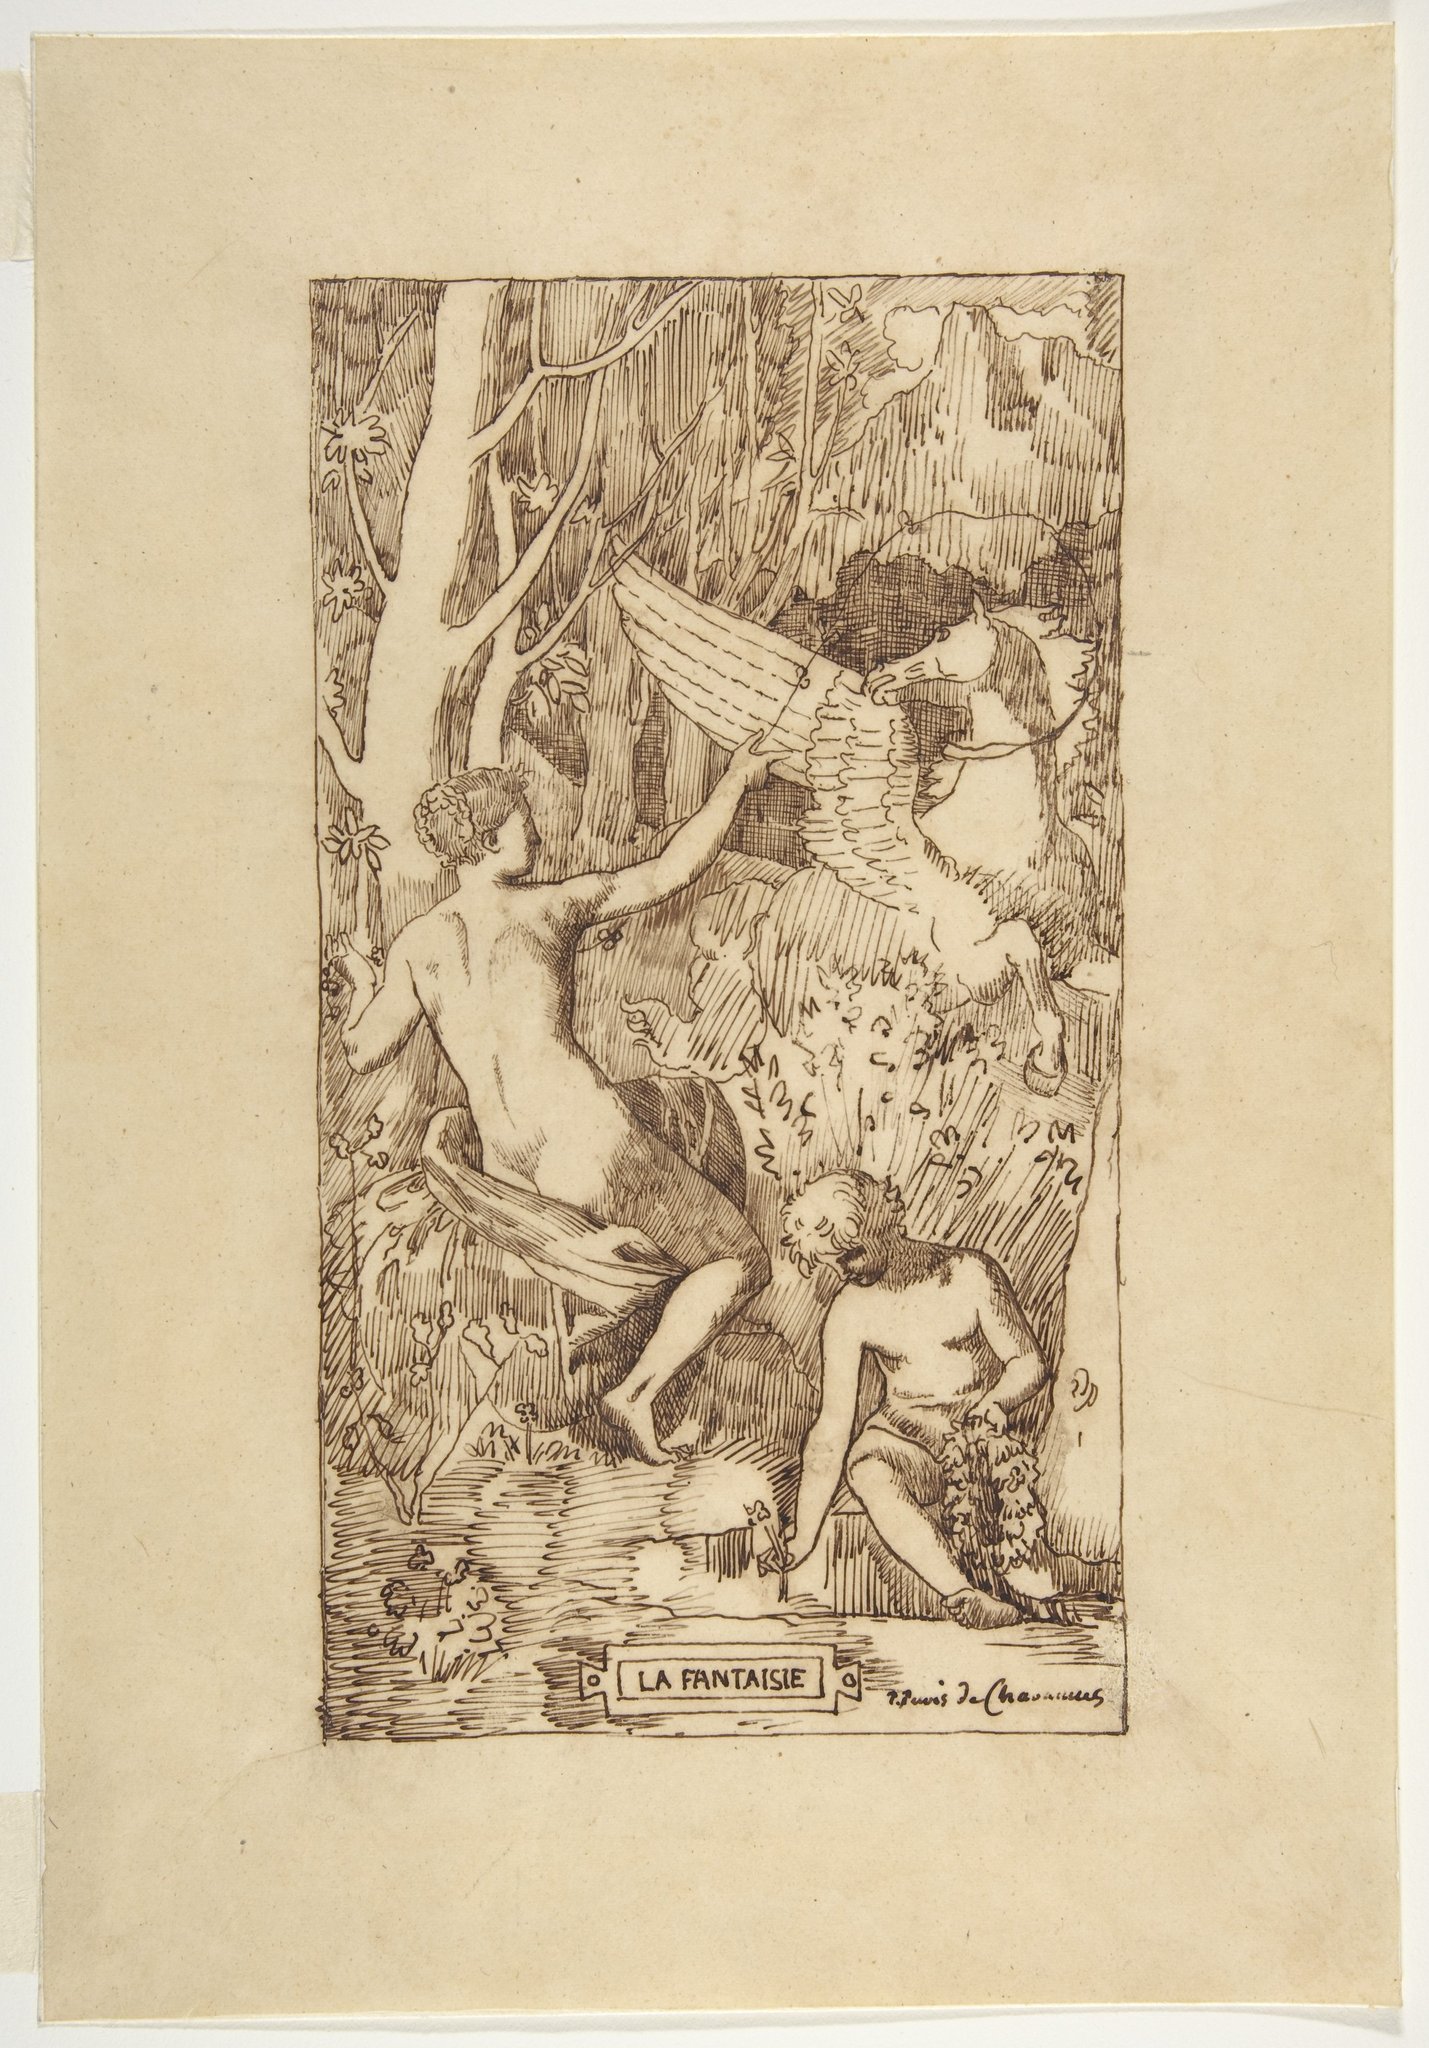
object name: drawing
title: Fantasy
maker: pierre puvis de chavannes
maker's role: artist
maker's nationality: french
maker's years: 1824-1898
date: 1824-1898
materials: ink, paper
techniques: pen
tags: male nudes,pegasus